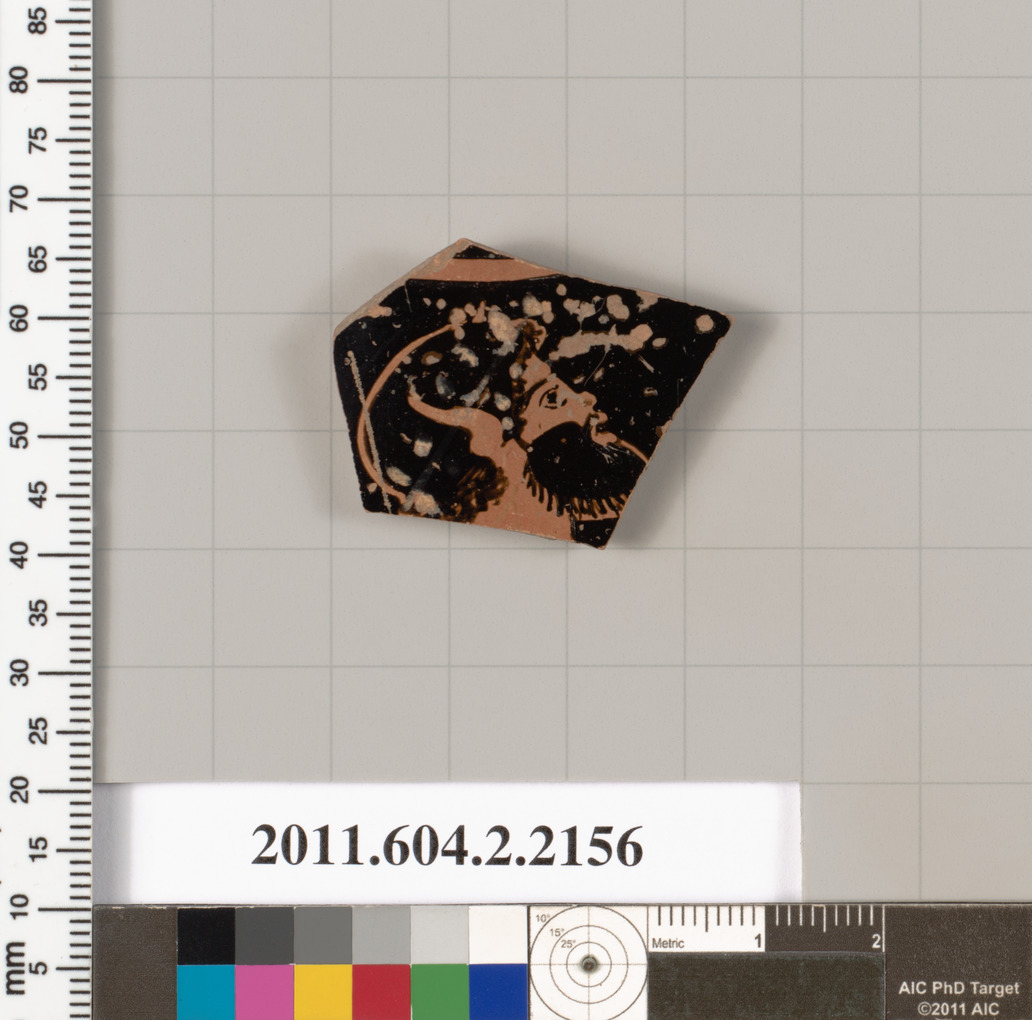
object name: pot fragment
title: Terracotta fragment of a pot; unglazed on the inside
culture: greek, attic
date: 490-470 BCE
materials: terracotta